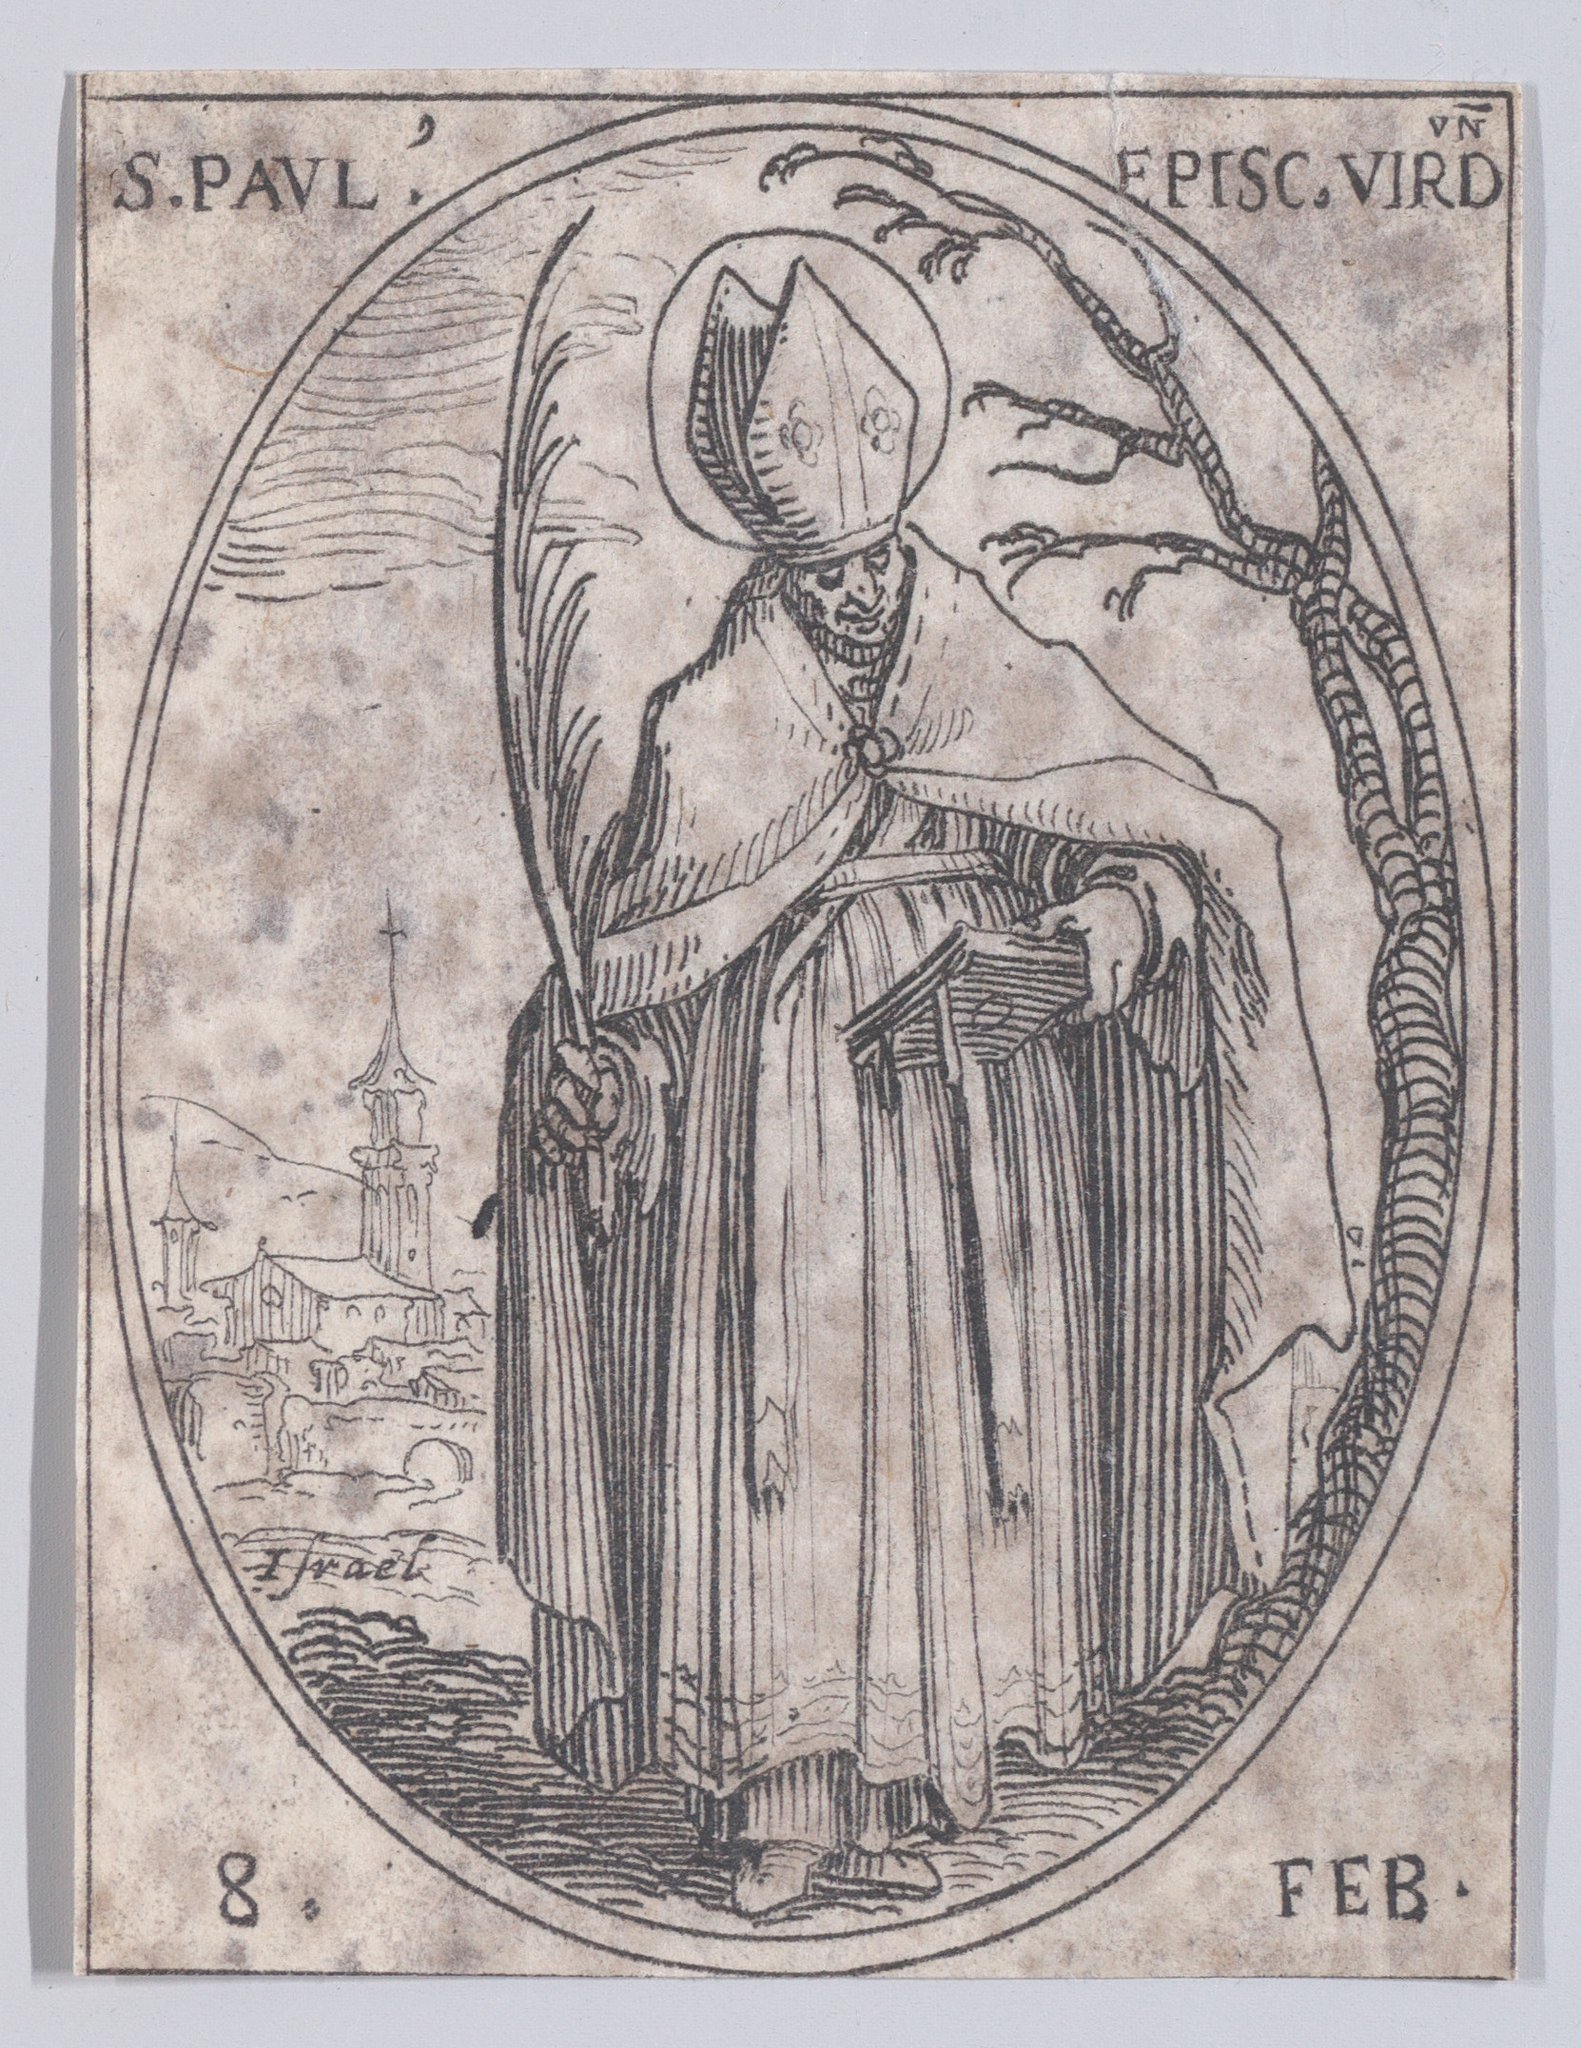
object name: print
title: S. Paul, évêque de Verdun (St. Paul, Bishop of Verdun), February 8th, from "Les Images De Tous Les Saincts et Saintes de L'Année" (Images of All of the Saints and Feast Days of the Year)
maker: jacques callot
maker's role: artist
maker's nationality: french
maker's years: 1592-1635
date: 1636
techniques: etching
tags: men,saints